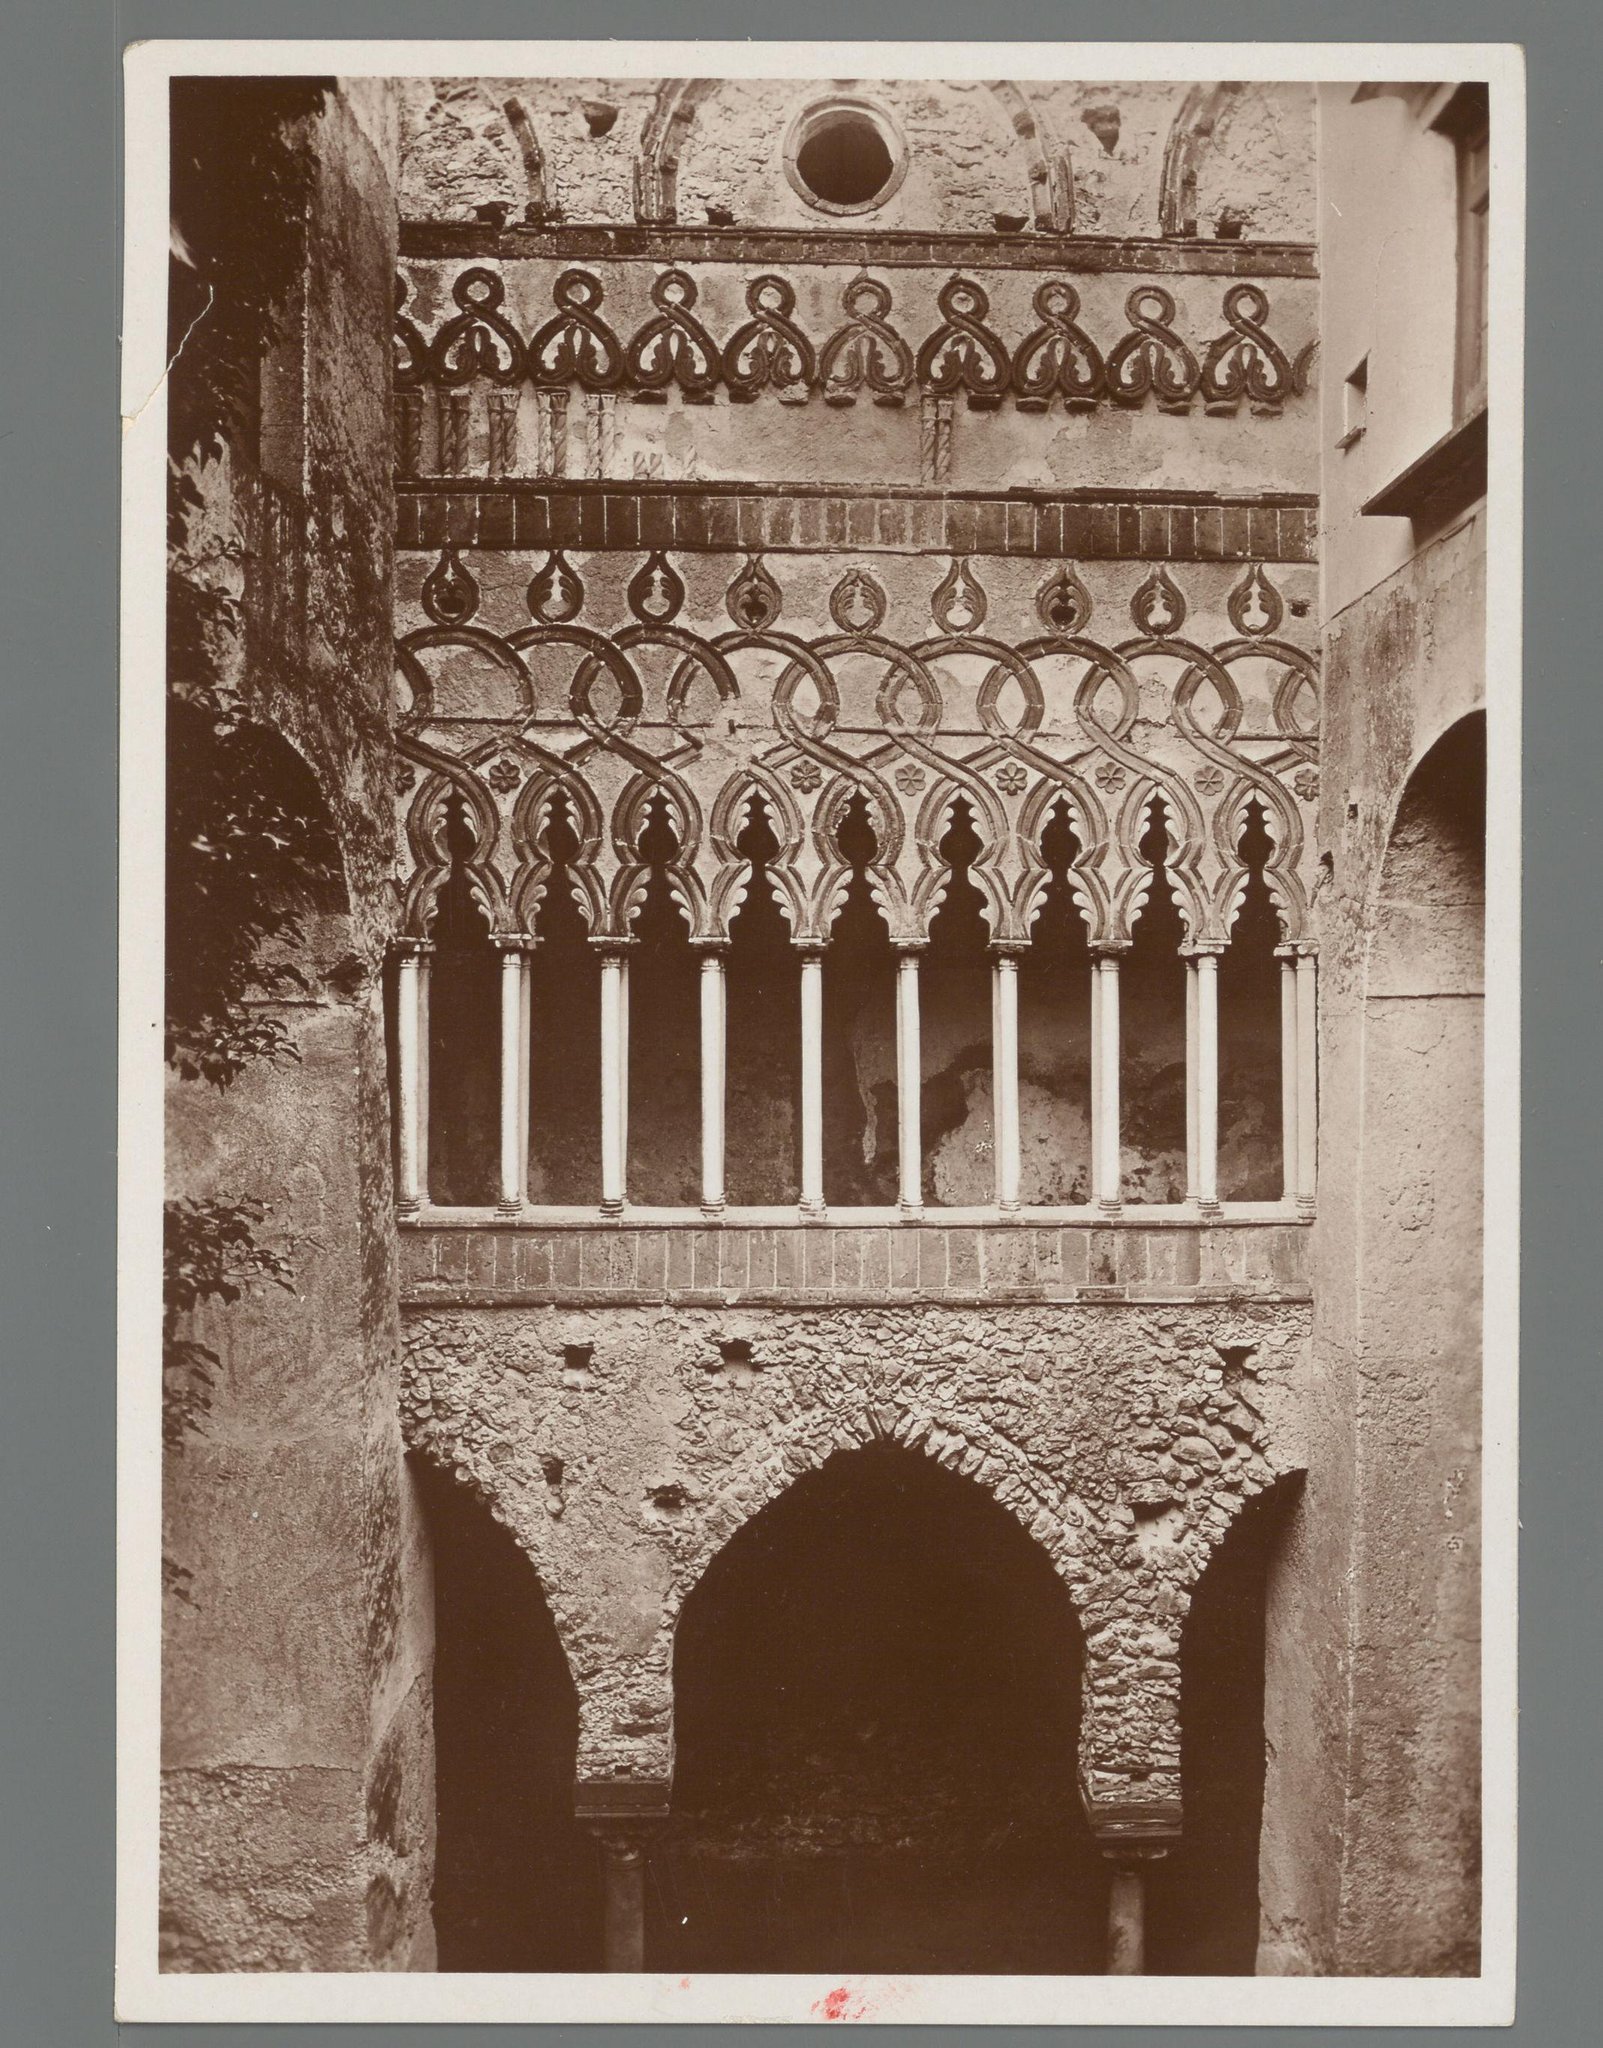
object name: ansichtkaart, prentbriefkaart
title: Ravello. Palazzo Rufolo. Antico cortile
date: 1940-1960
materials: photographic support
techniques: photography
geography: italy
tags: palace, inner court of palace or 'hôtel'